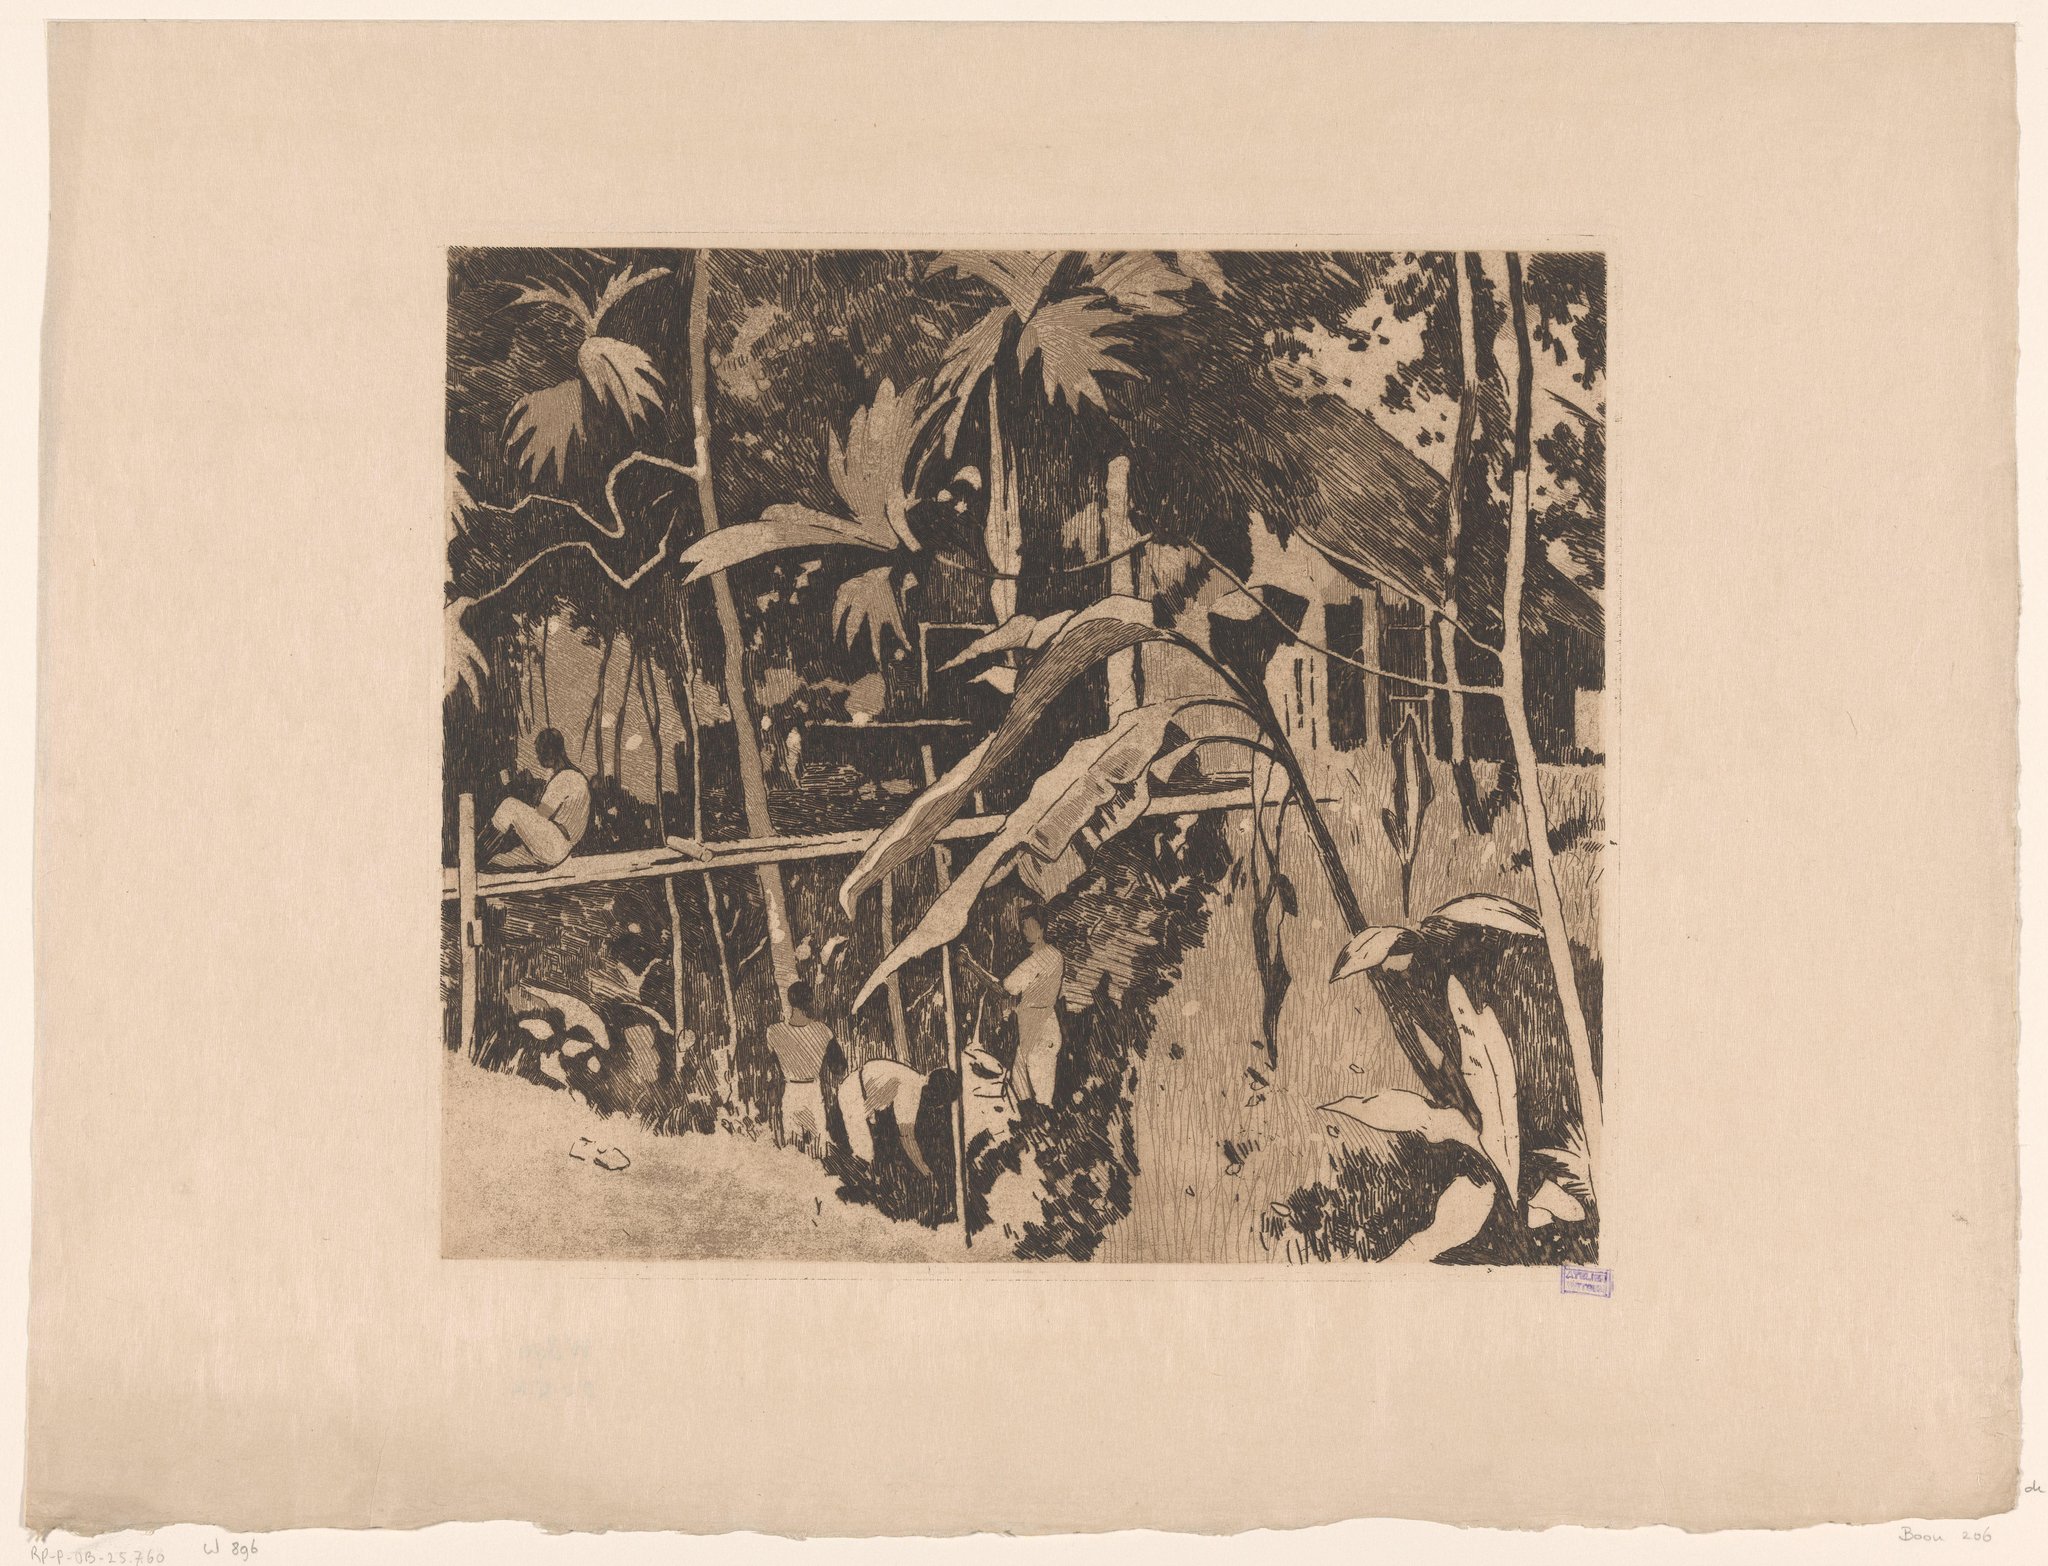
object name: print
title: Begroeiing en een smalle brug in Buitenzorg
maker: willem witsen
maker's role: draughtsman, painter, print maker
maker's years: 1860-1923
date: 1921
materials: paper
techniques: aquatint, etching, intaglio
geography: amsterdam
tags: plantation, postures of the human figure, bridge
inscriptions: collector's mark: Lugt 2583b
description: Op de voorgrond vier figuren. Rechtsachter is een dak van een huis zichtbaar.